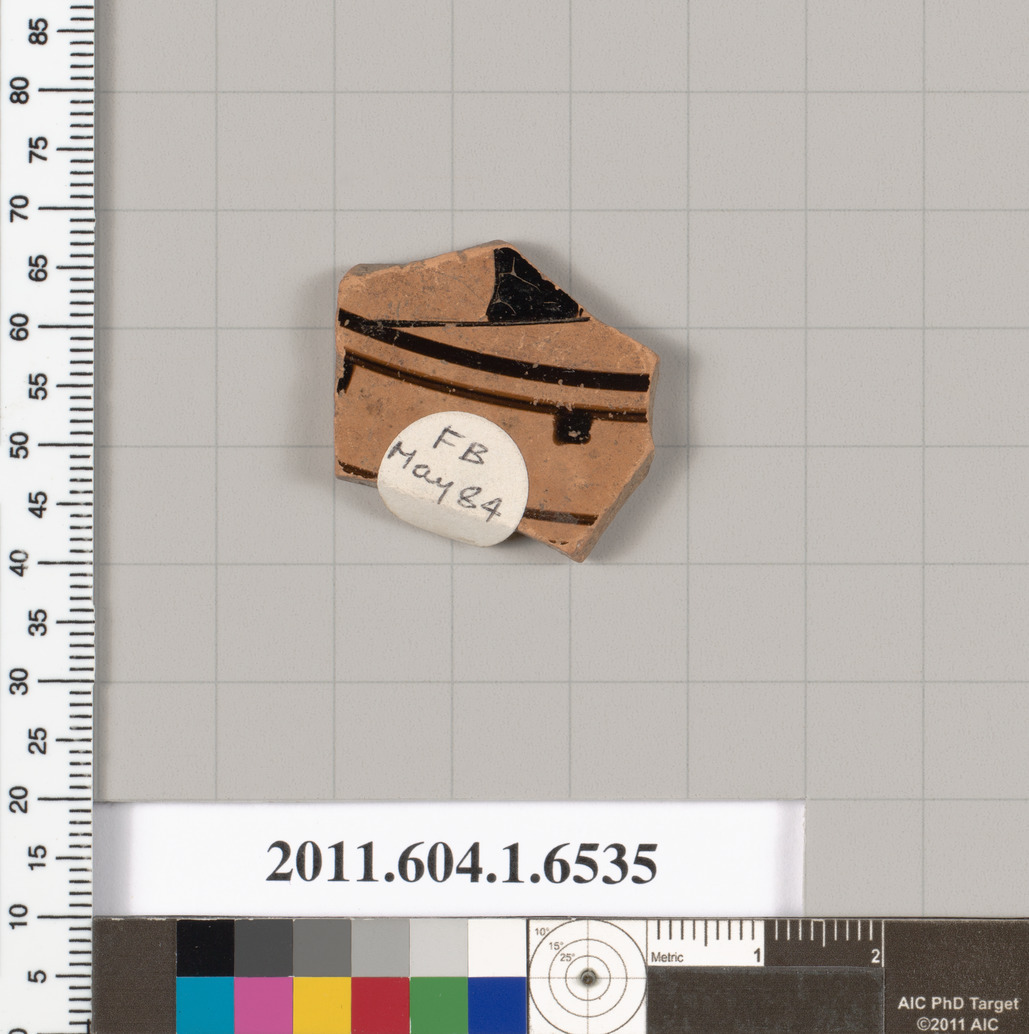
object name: kylix fragment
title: Terracotta fragment of a kylix (drinking cup)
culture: greek, attic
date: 490-480 BCE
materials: terracotta